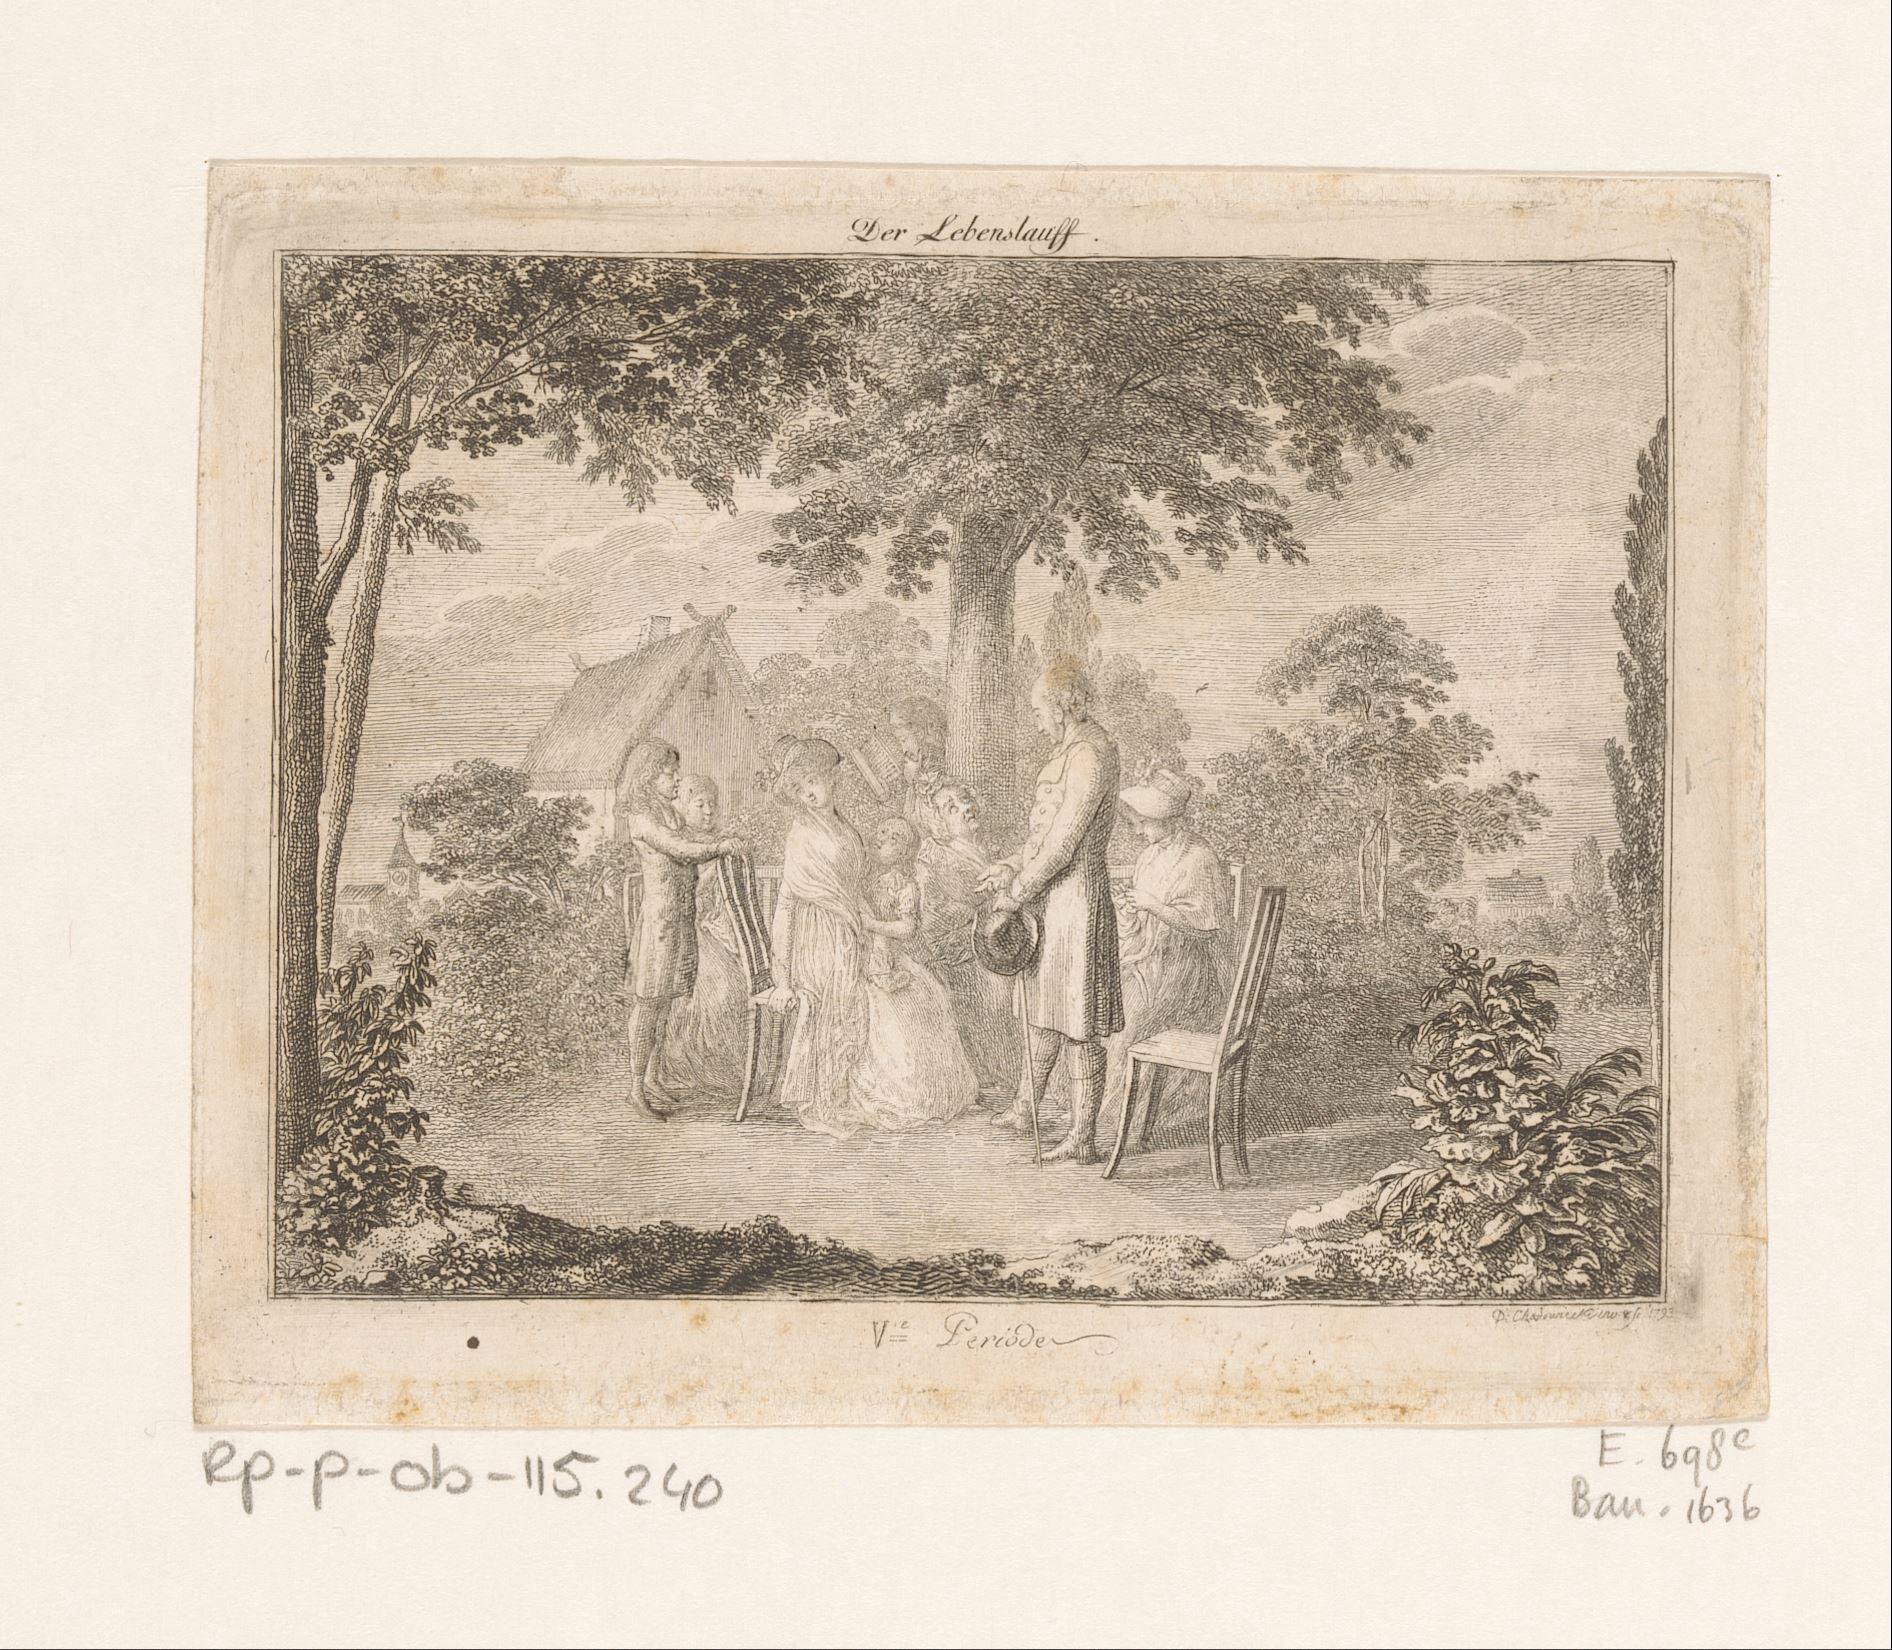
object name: print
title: Oudere man keert terug naar zijn gezin als vijfde periode van de levensloop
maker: daniel nikolaus chodowiecki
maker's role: draughtsman, print maker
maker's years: 1726-1801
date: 1793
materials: paper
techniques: etching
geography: berlin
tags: bench, child, old man, family, relationship, descent, farm or solitary house in landscape, the life of man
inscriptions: collector's mark: Lugt 2228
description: Onderdeel van een serie van acht prenten over de levensloop van de mens. Gedrukt met weinig inkt waardoor de afdruk vrij licht is.